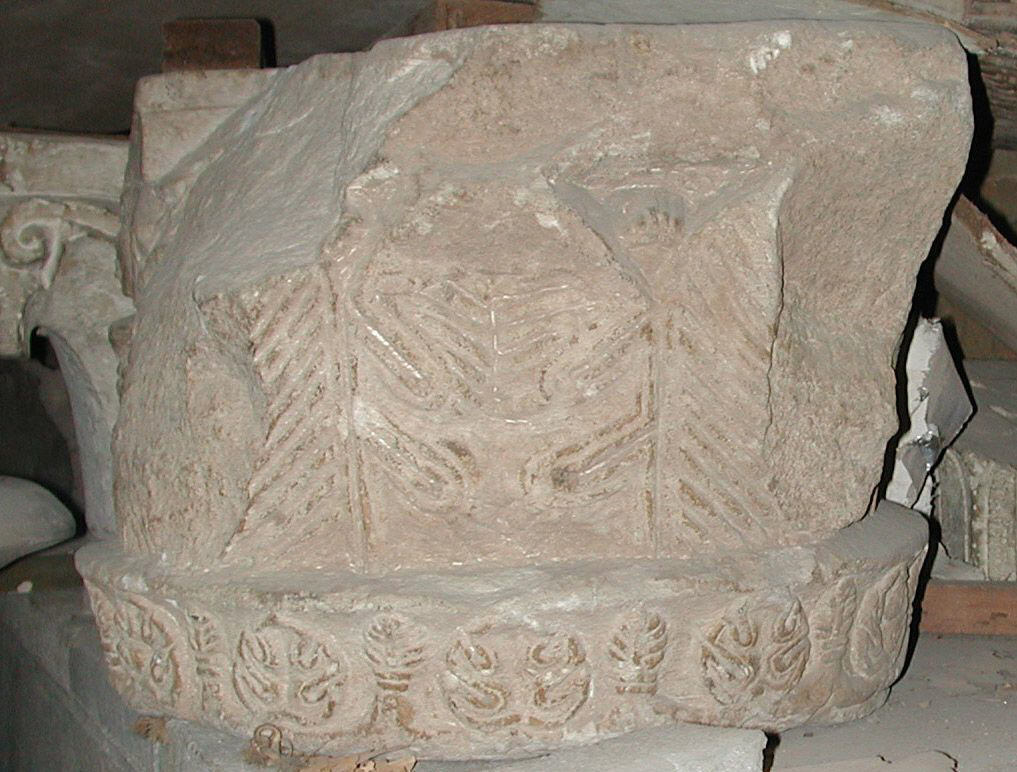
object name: capital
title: Capital with Leaves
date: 201-1200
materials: stone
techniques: carving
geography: egypt